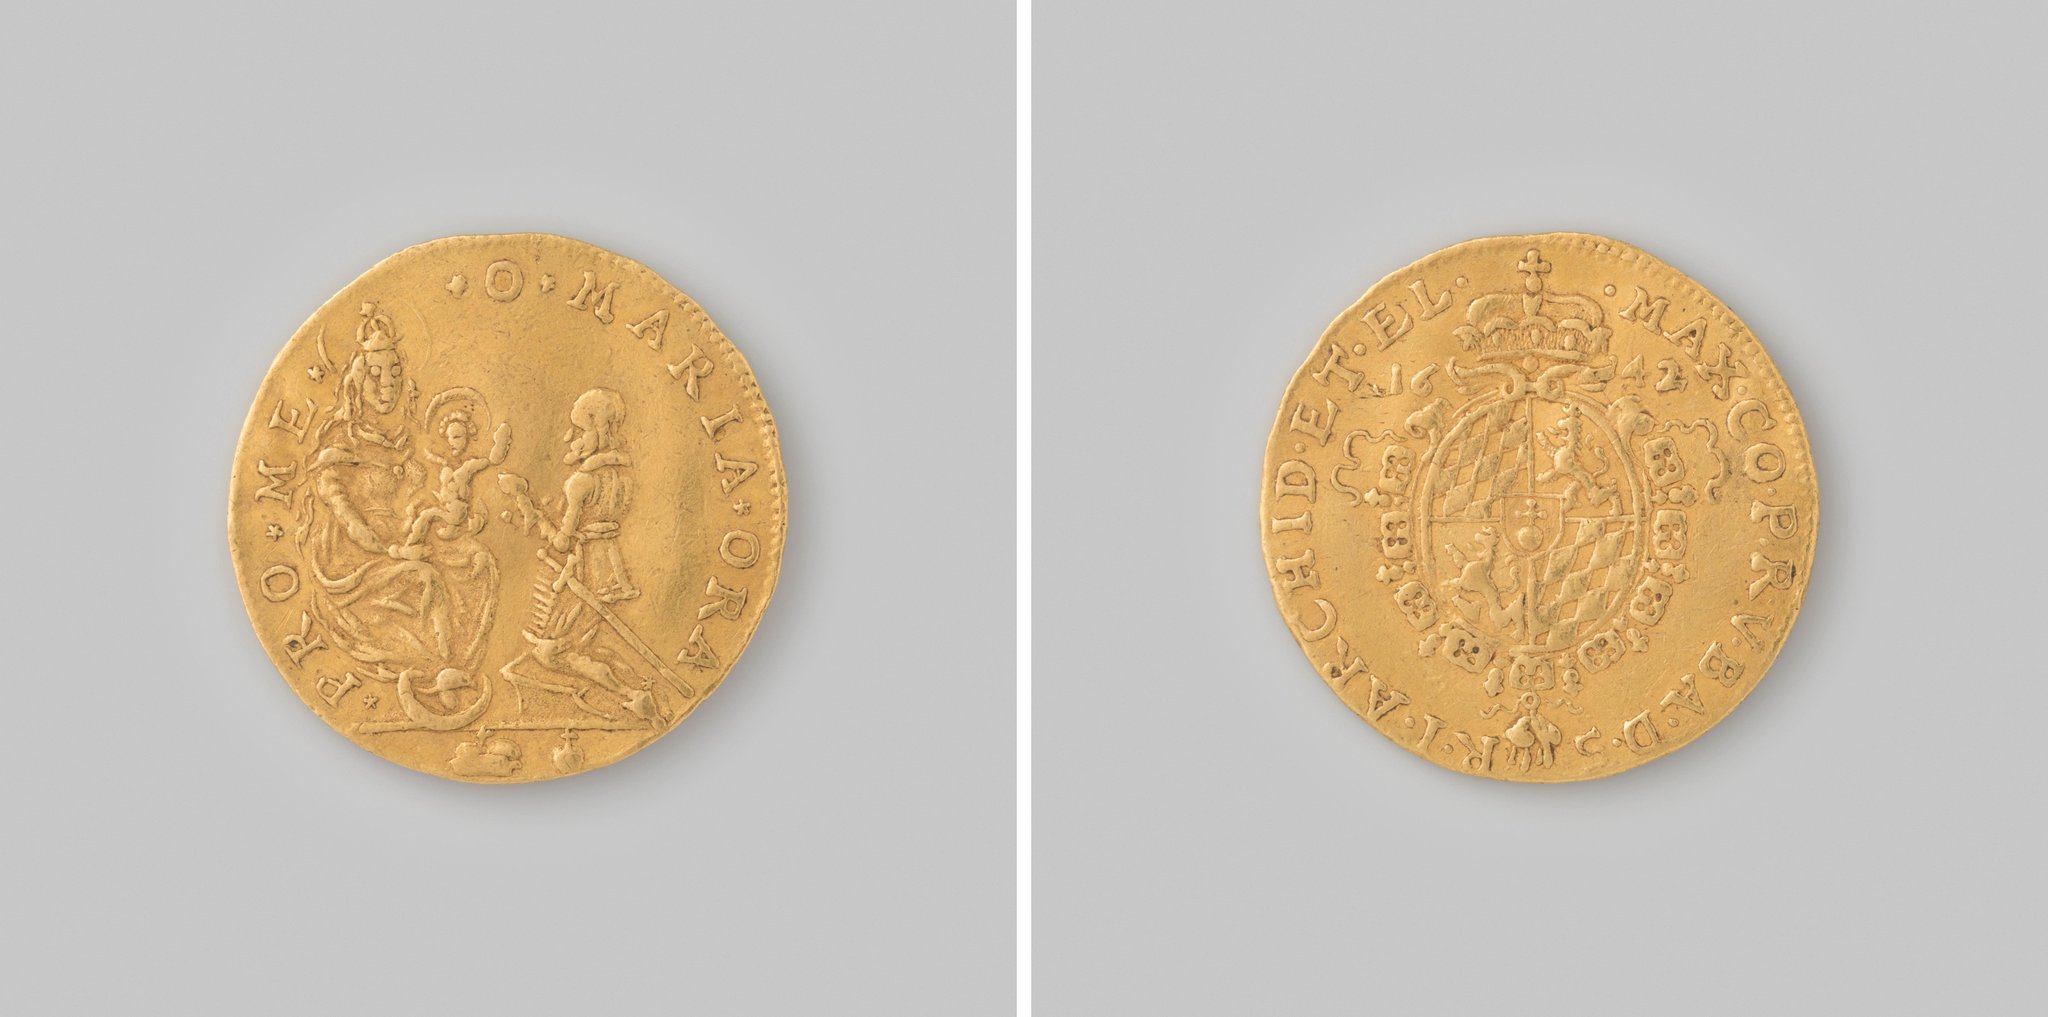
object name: ducat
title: Dukaat uit het hertogdom Beieren van keurvorst Maximilian I, 1642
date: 1642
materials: gold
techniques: striking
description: Gouden munt. Voorzijde:op bankje knielende keurvorst voor op maansikkel gezeten gekroonde Madonna met het kind. Keerzijde: tussen jaartal gekroond wapenschild, met keten en juweel van de Orde van het Gulden Vlies omhangen.